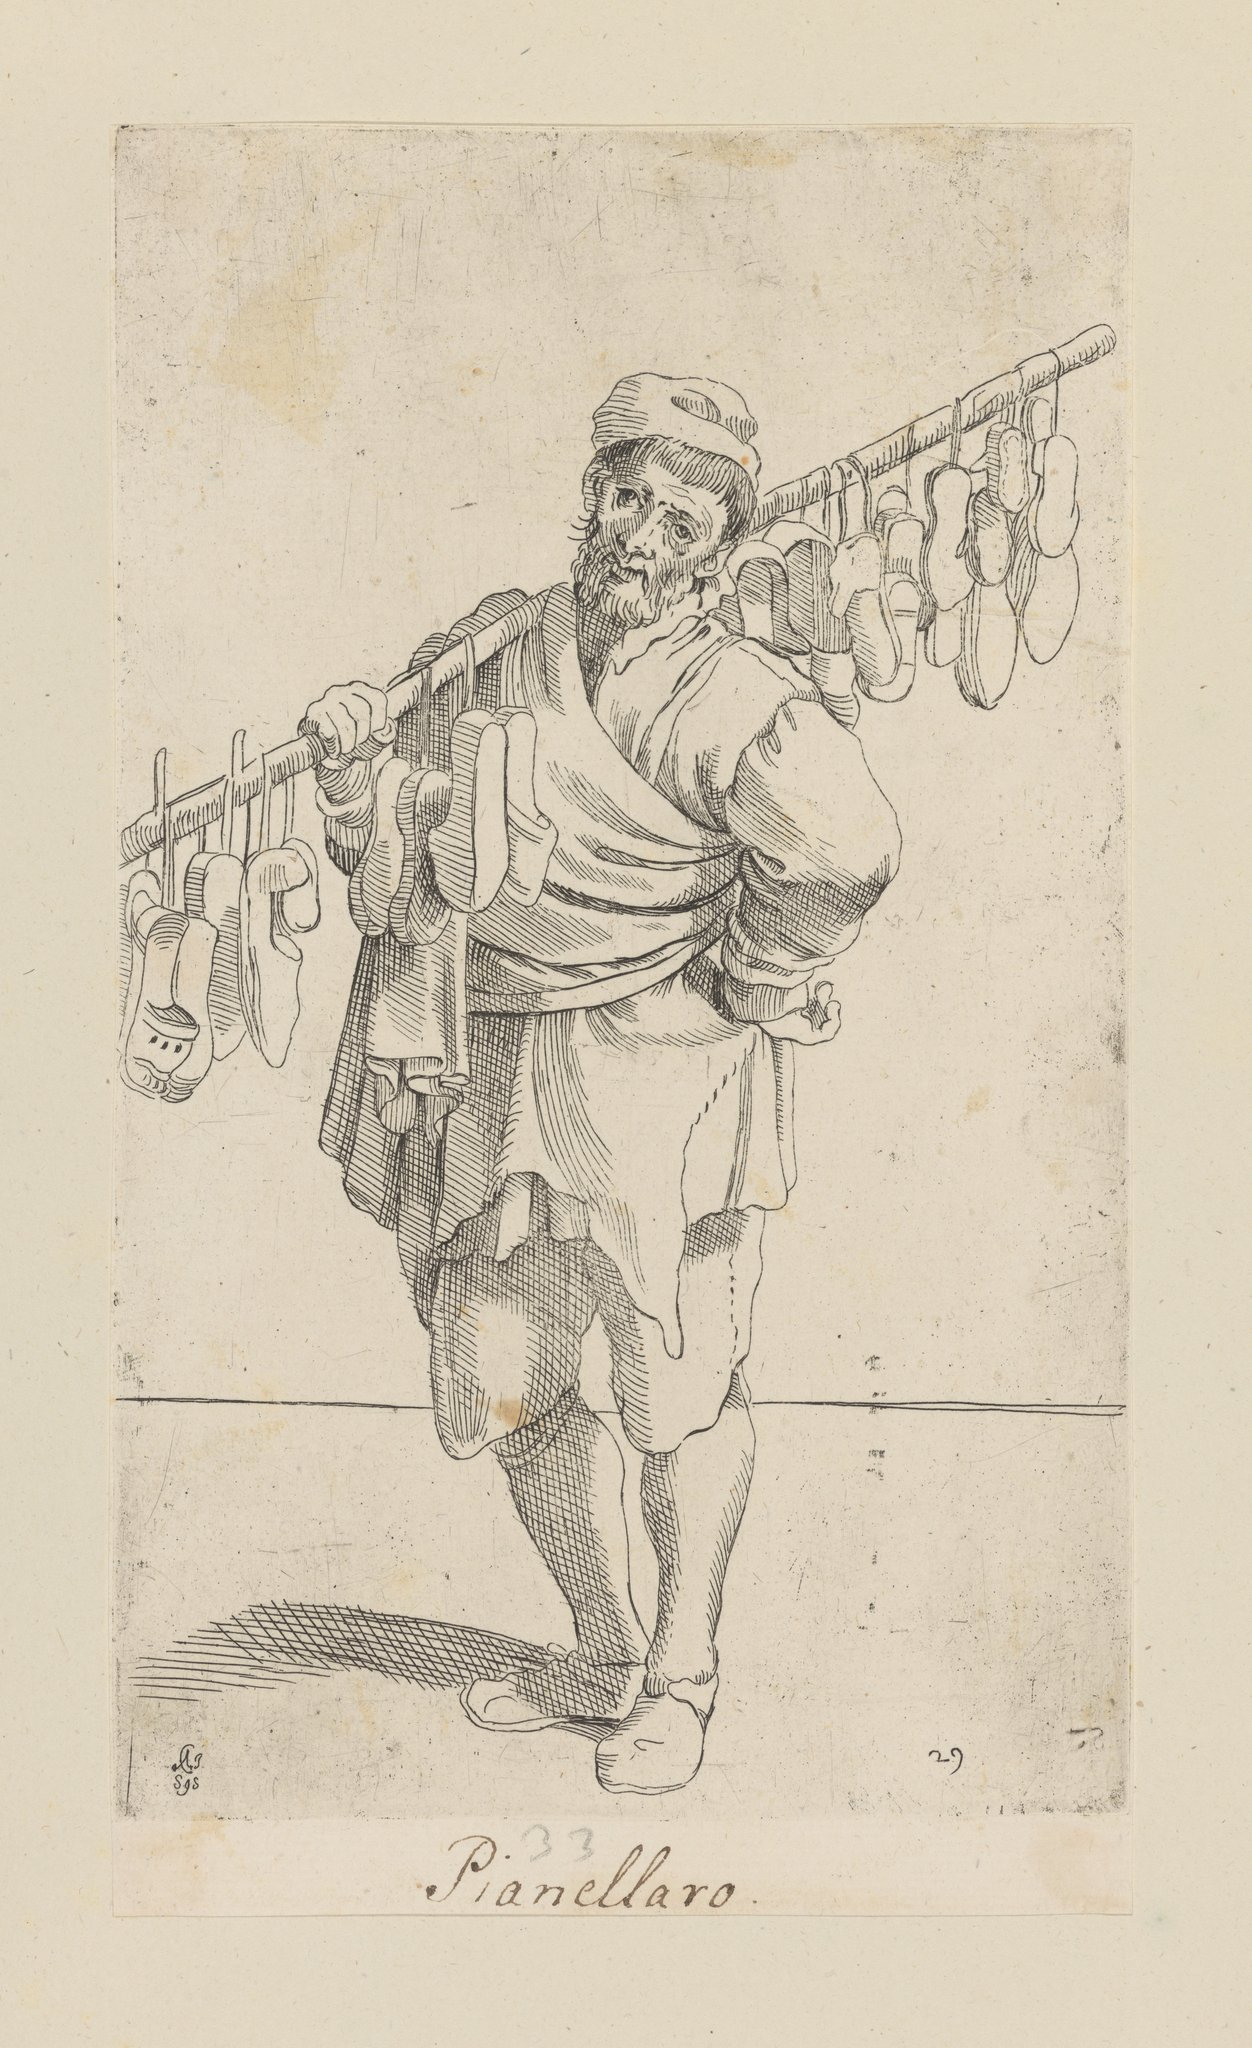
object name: print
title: Plate 29: vendor of slippers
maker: simon guillain ii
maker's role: artist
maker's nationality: french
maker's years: 1618-1718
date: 1646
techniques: etching